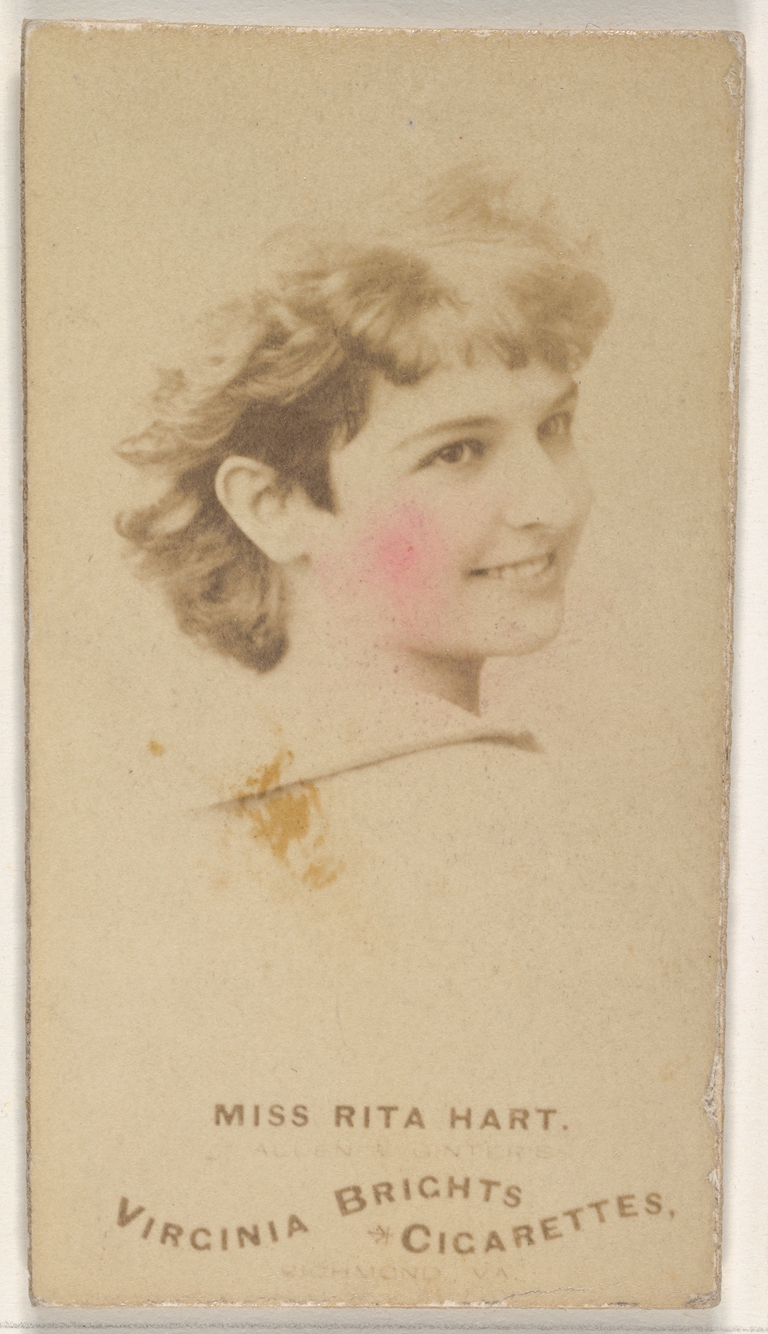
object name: photograph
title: Miss Rita Hart, from the Actors and Actresses series (N45, Type 1) for Virginia Brights Cigarettes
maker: allen & ginter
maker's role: publisher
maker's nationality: american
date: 1888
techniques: albumen silver print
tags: portraits,women,actresses